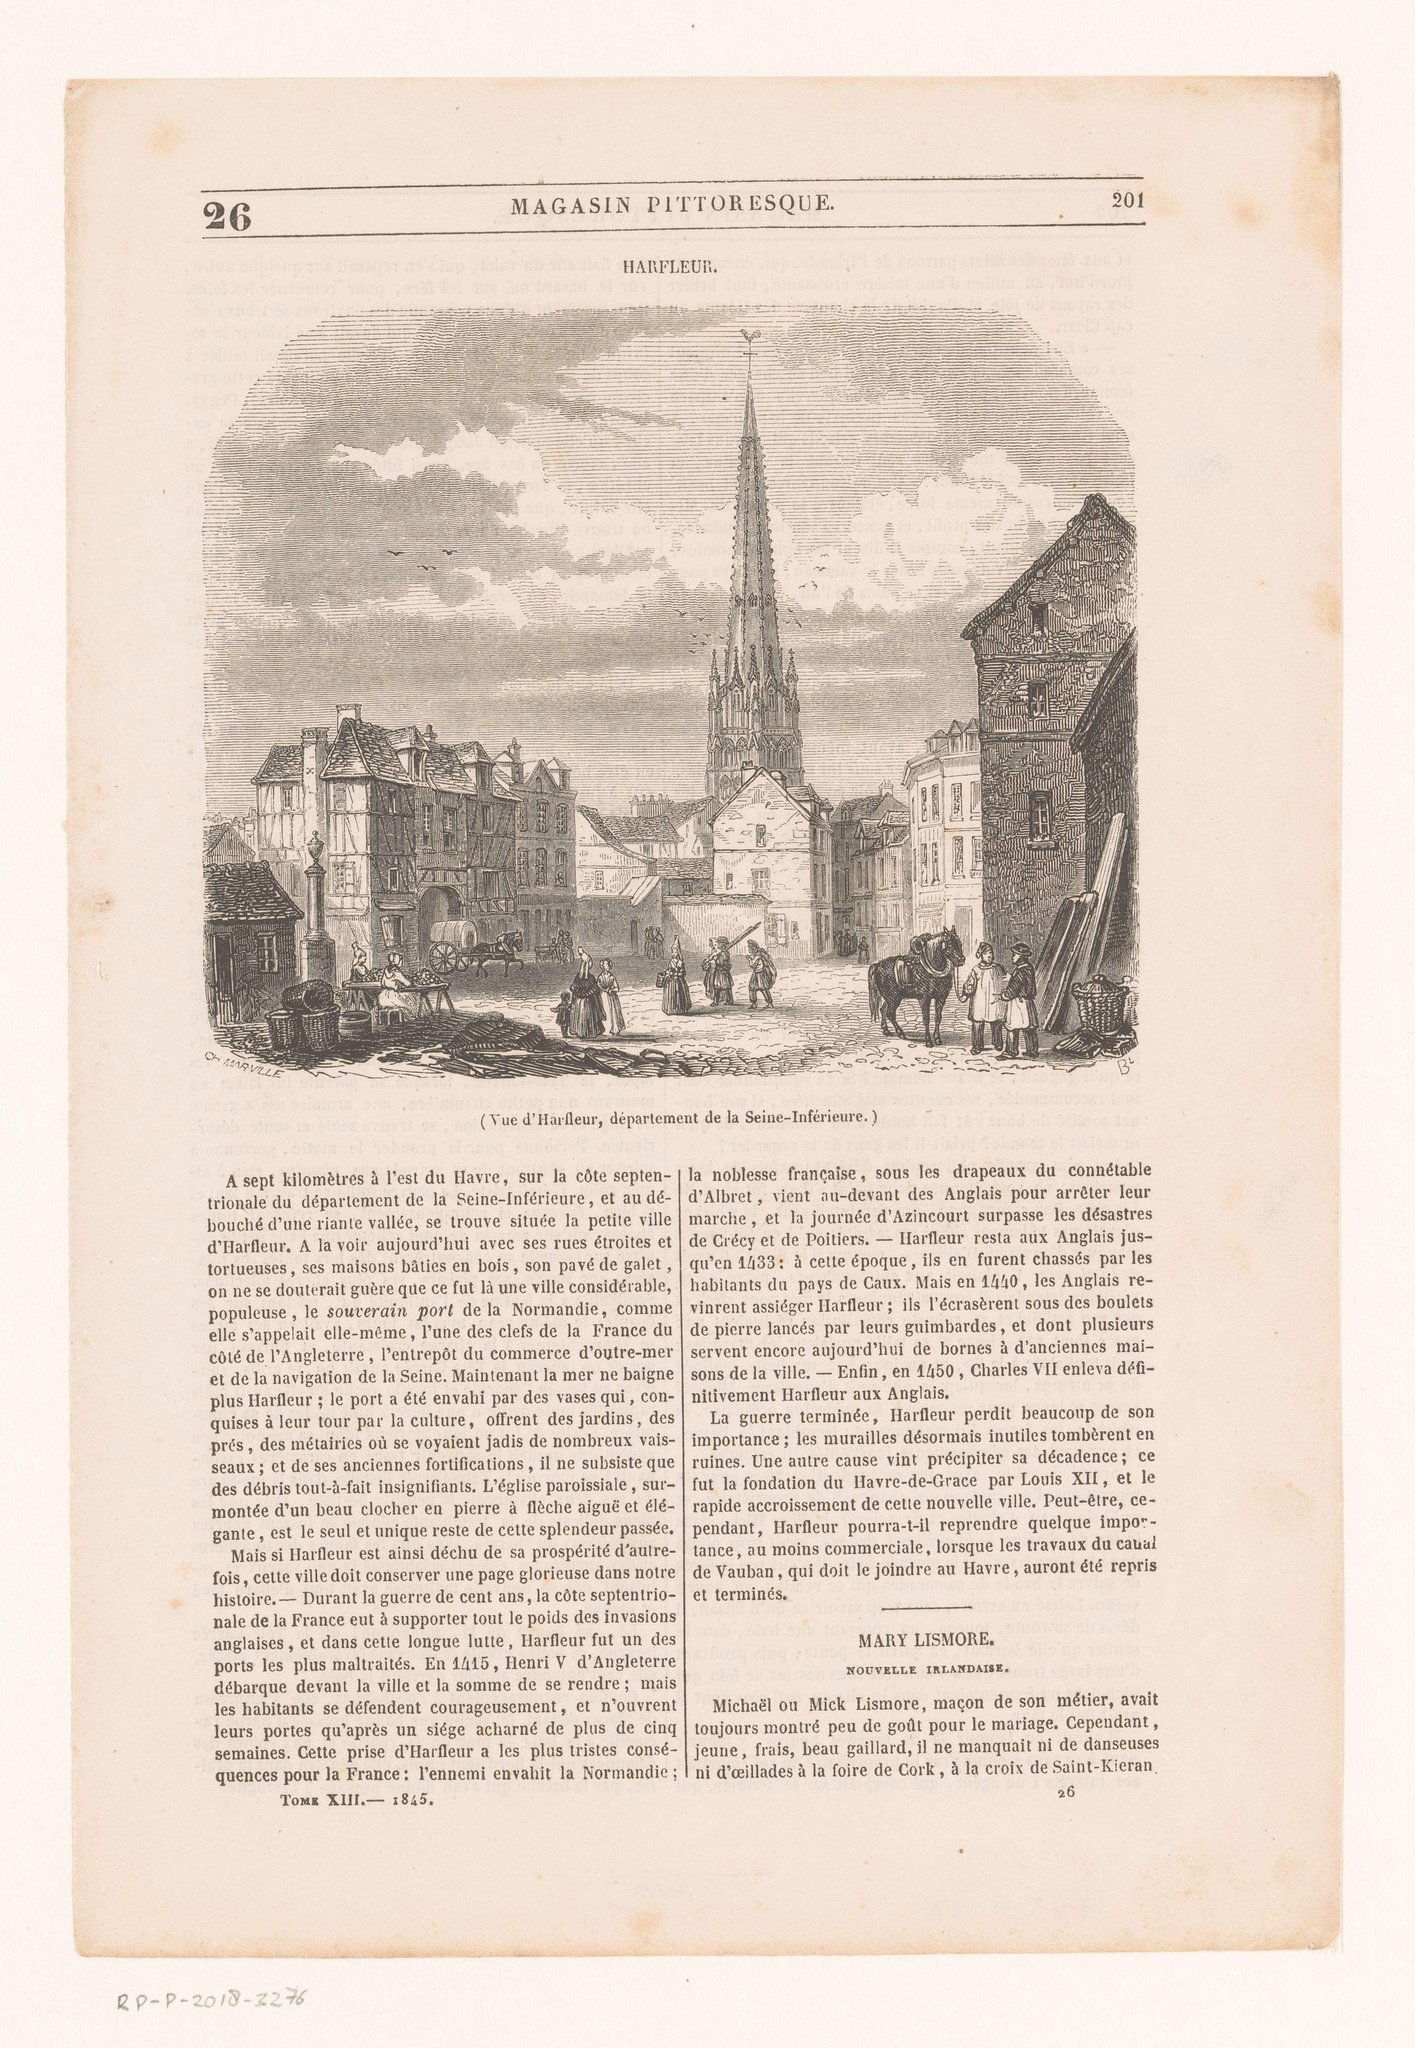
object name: page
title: Vue d'Harfleur, département de la Seine-Inférieure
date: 1845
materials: paper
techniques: letterpress printing, engraving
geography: paris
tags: landscape with tower or castle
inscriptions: collector's mark: Lugt 2228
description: Gezicht op een plein in Harfleur met op de achtergrond de Sint-Martinuskerk.